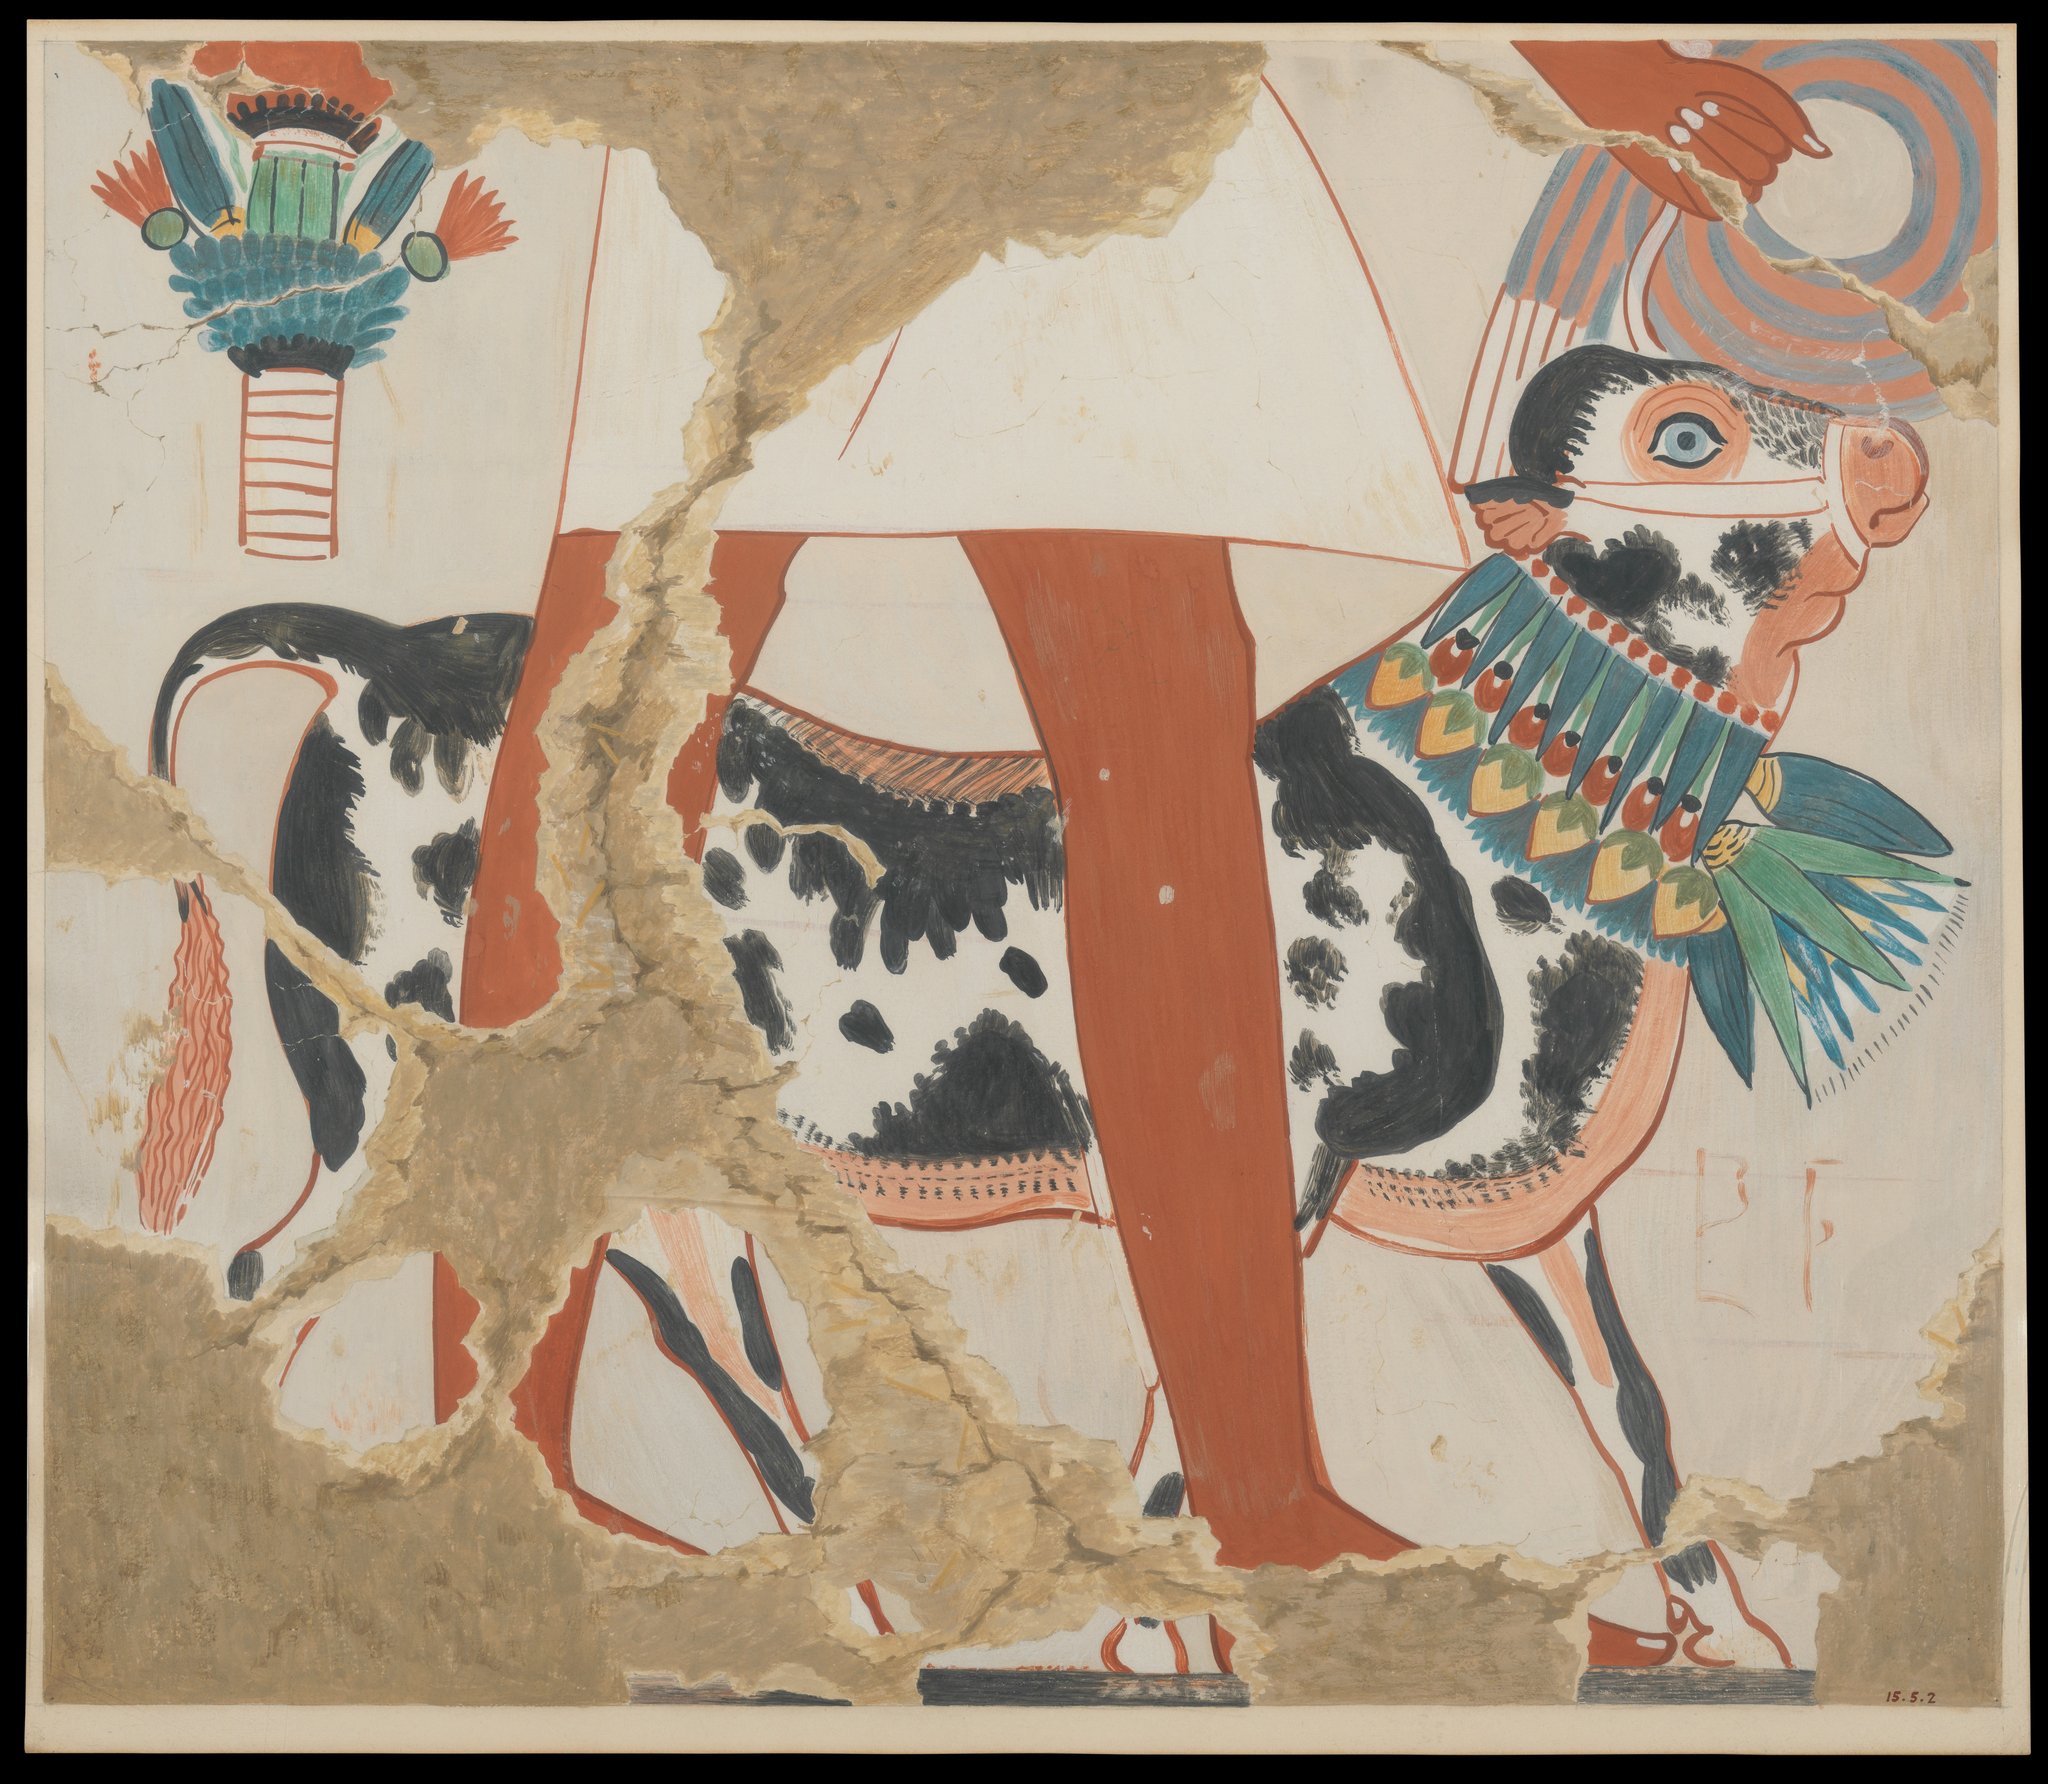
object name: facsimile, tt 226, offering procession, bull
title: Detail of a Bull from a Procession of Offering Bearers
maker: nina de garis davies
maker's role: artist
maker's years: 1881-1965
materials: paper, paint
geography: egypt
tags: bulls